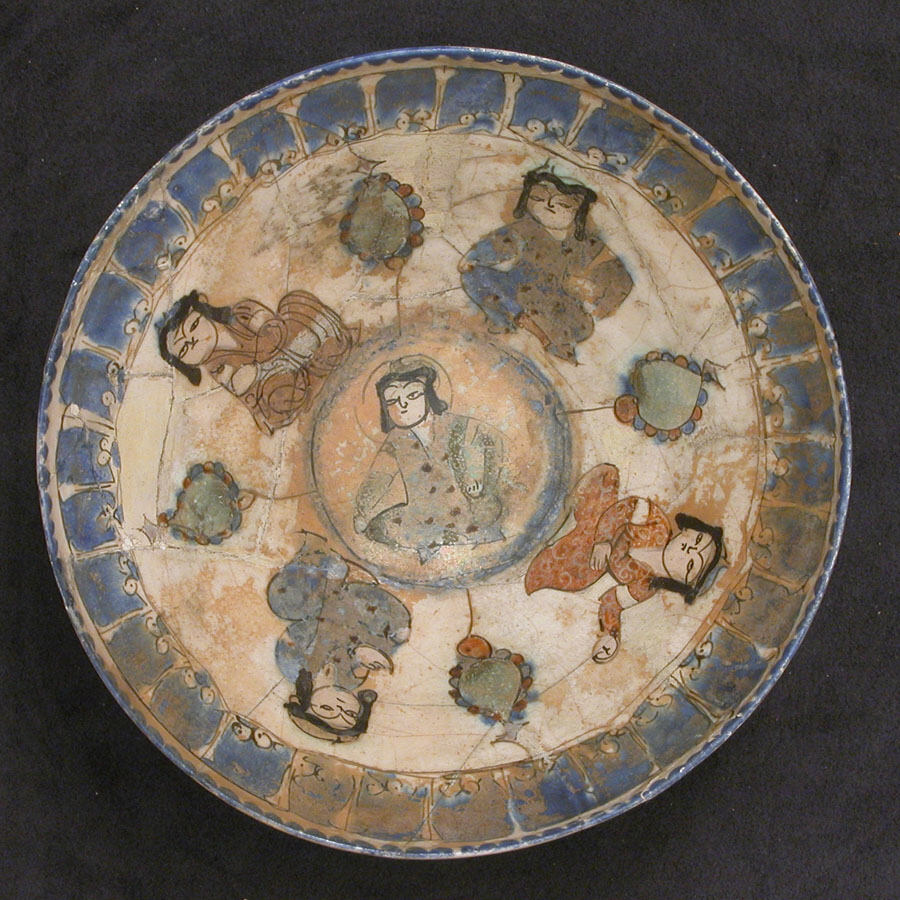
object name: bowl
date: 1101-1300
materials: stonepaste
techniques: overglaze, painting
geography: iran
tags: human figures